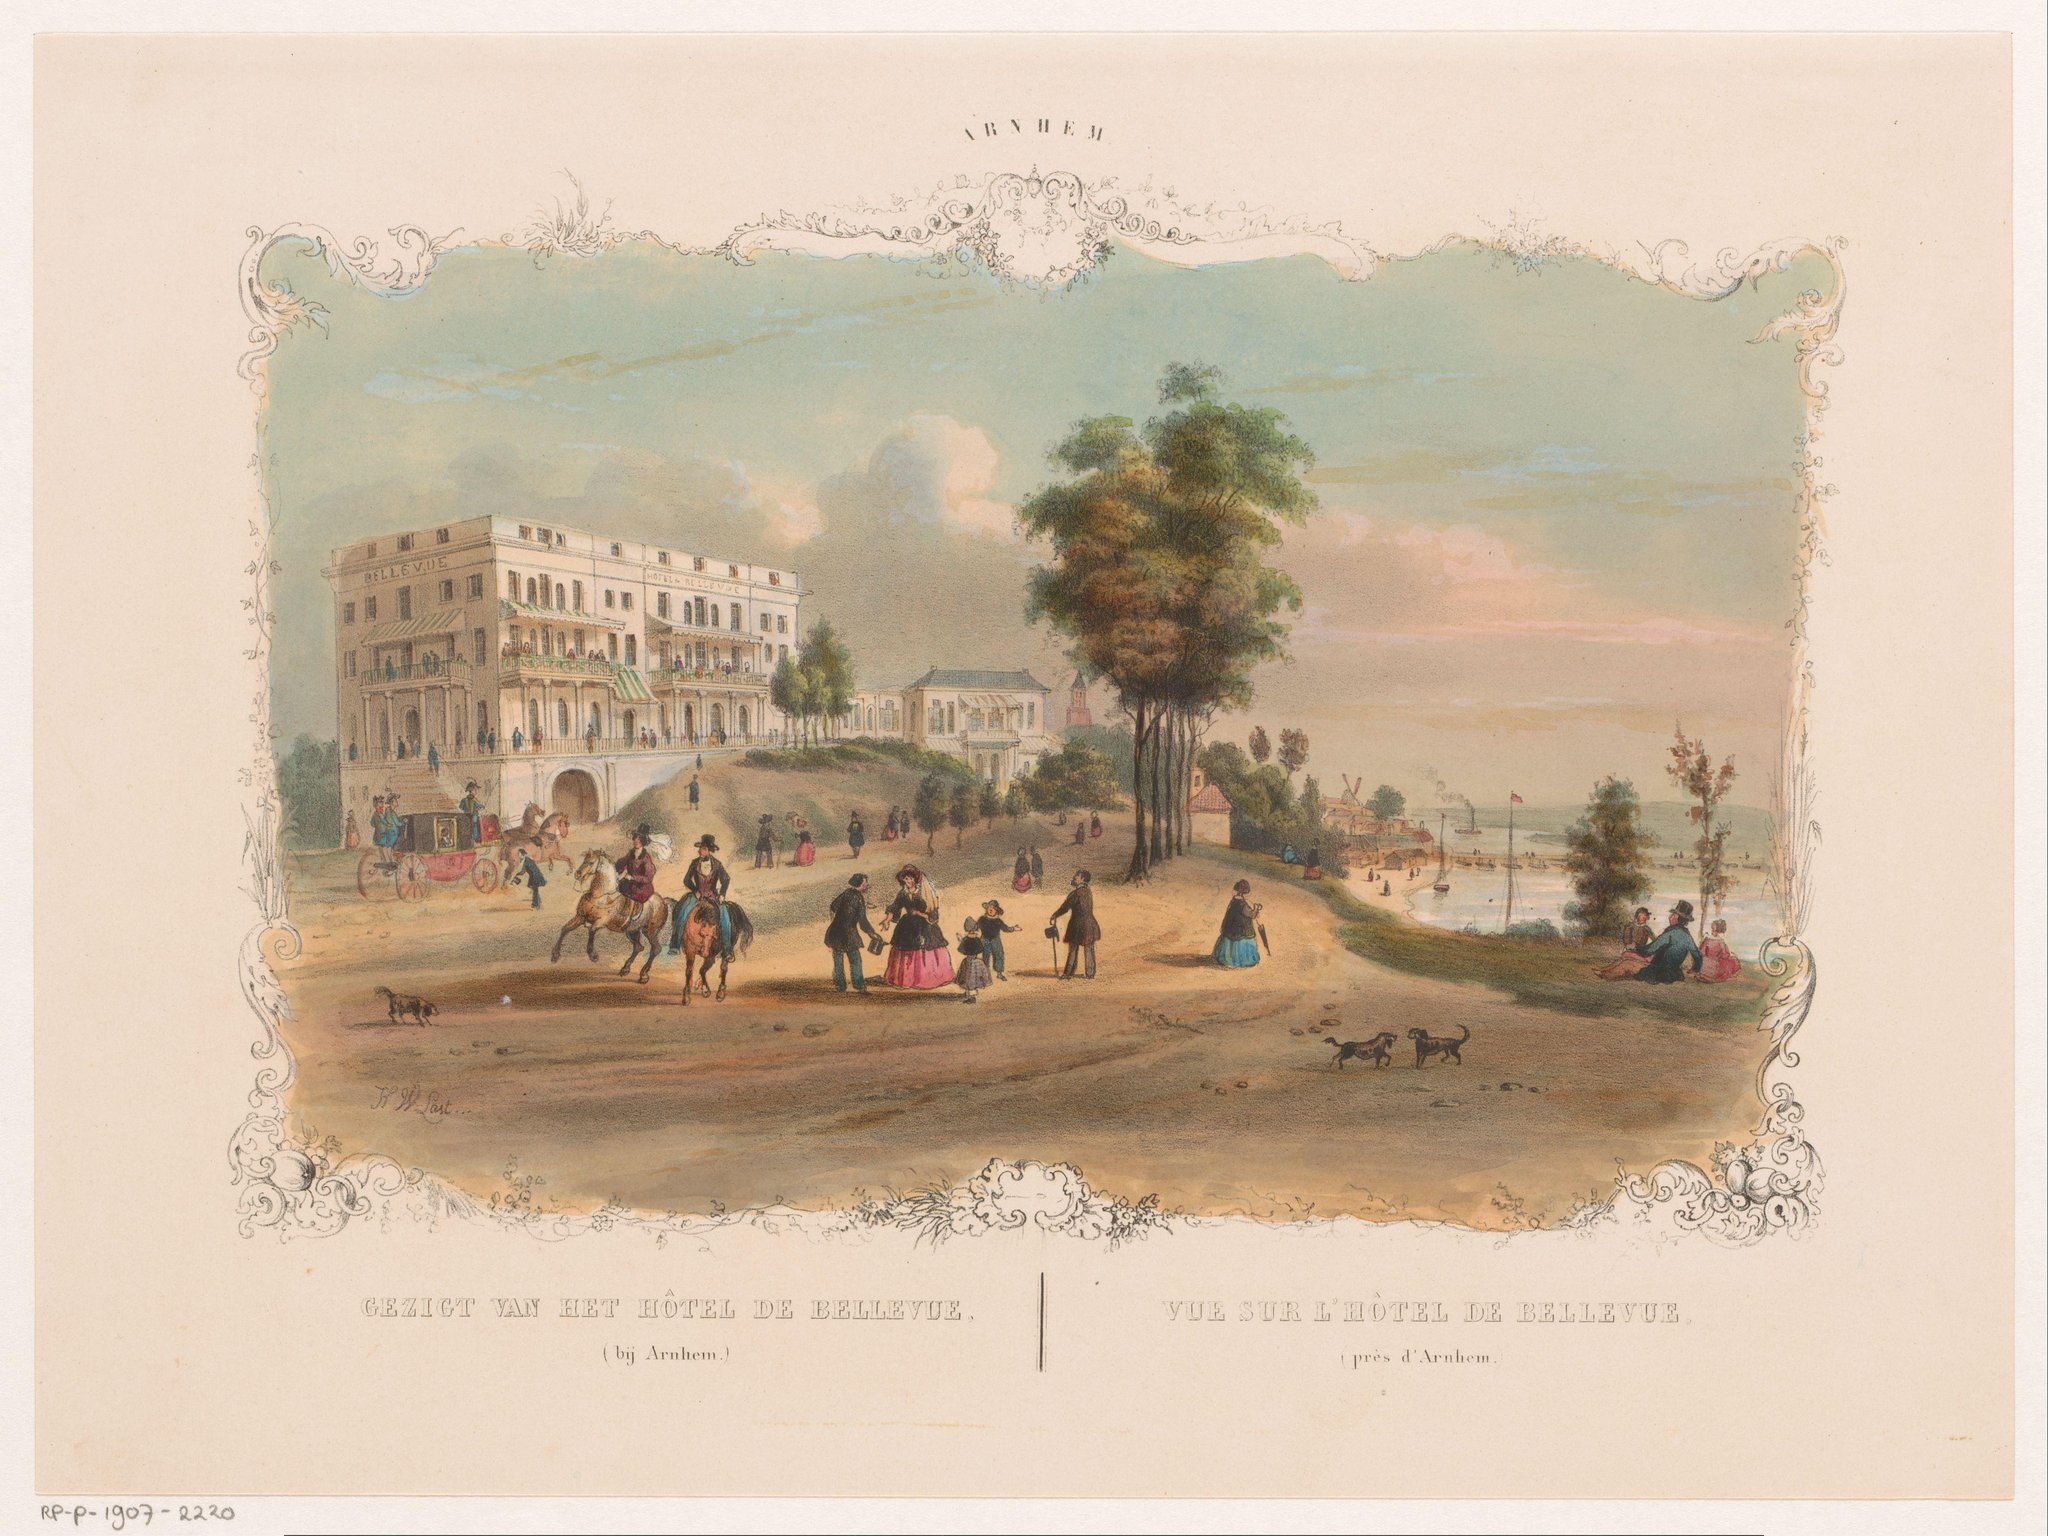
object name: print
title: Gezicht op het hotel Bellevue bij Arnhem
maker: hendrik wilhelmus last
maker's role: print maker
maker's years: 1817-1873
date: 1827-1873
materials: paper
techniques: hand coloring, lithograph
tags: river (+ landscape with figures, staffage), hotel, hostelry, inn, arnhem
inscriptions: collector's mark: Lugt 2228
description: Uitgegeven in: Een cahier van gezigten van Arnhem. De serie bestaat uit 12 prenten.